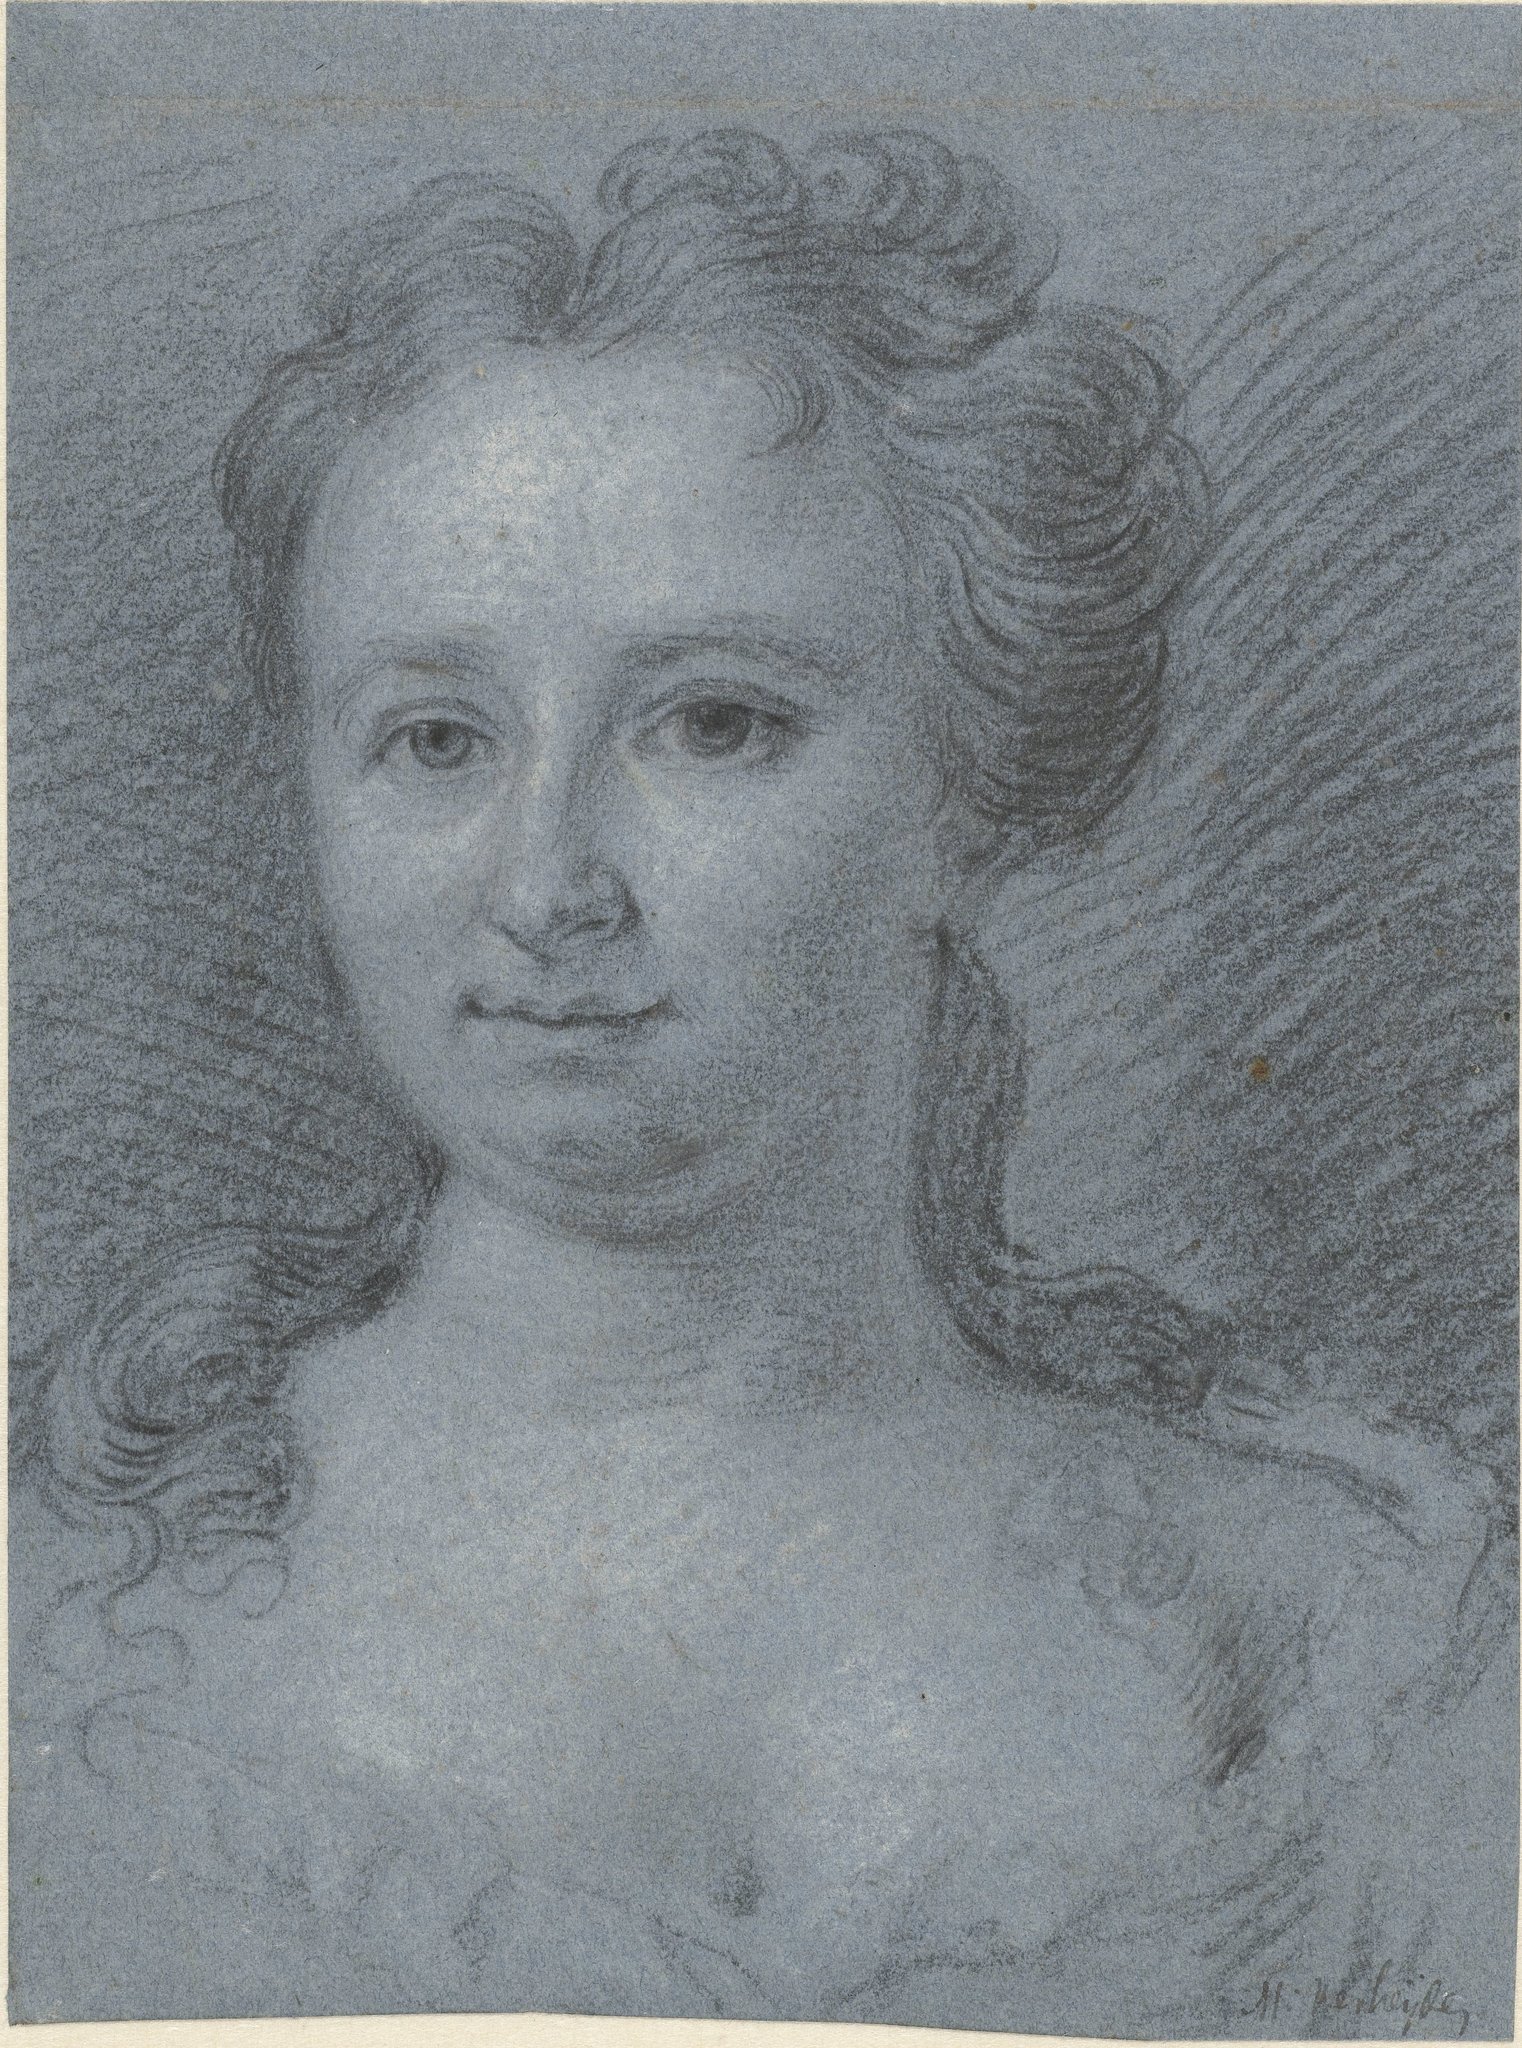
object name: drawing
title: Portret van een mejuffrouw Swiers geboren Moleneyser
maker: mattheus verheyden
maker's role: draughtsman, painter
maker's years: 1700-1777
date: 1710-1777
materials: chalk, paper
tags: historical persons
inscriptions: signature: ‘M: Verheijden’, inscription: ‘Mejuffw Swiers geboren / Moleneijser / M. Verheijden’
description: Afkomstig uit een tekeningenalbum met onder andere figuur- en handstudies van of naar Caspar en Constantijn Netscher (BI-1894-3720). Tekening bevond zich oorspronkelijk op f. 45.